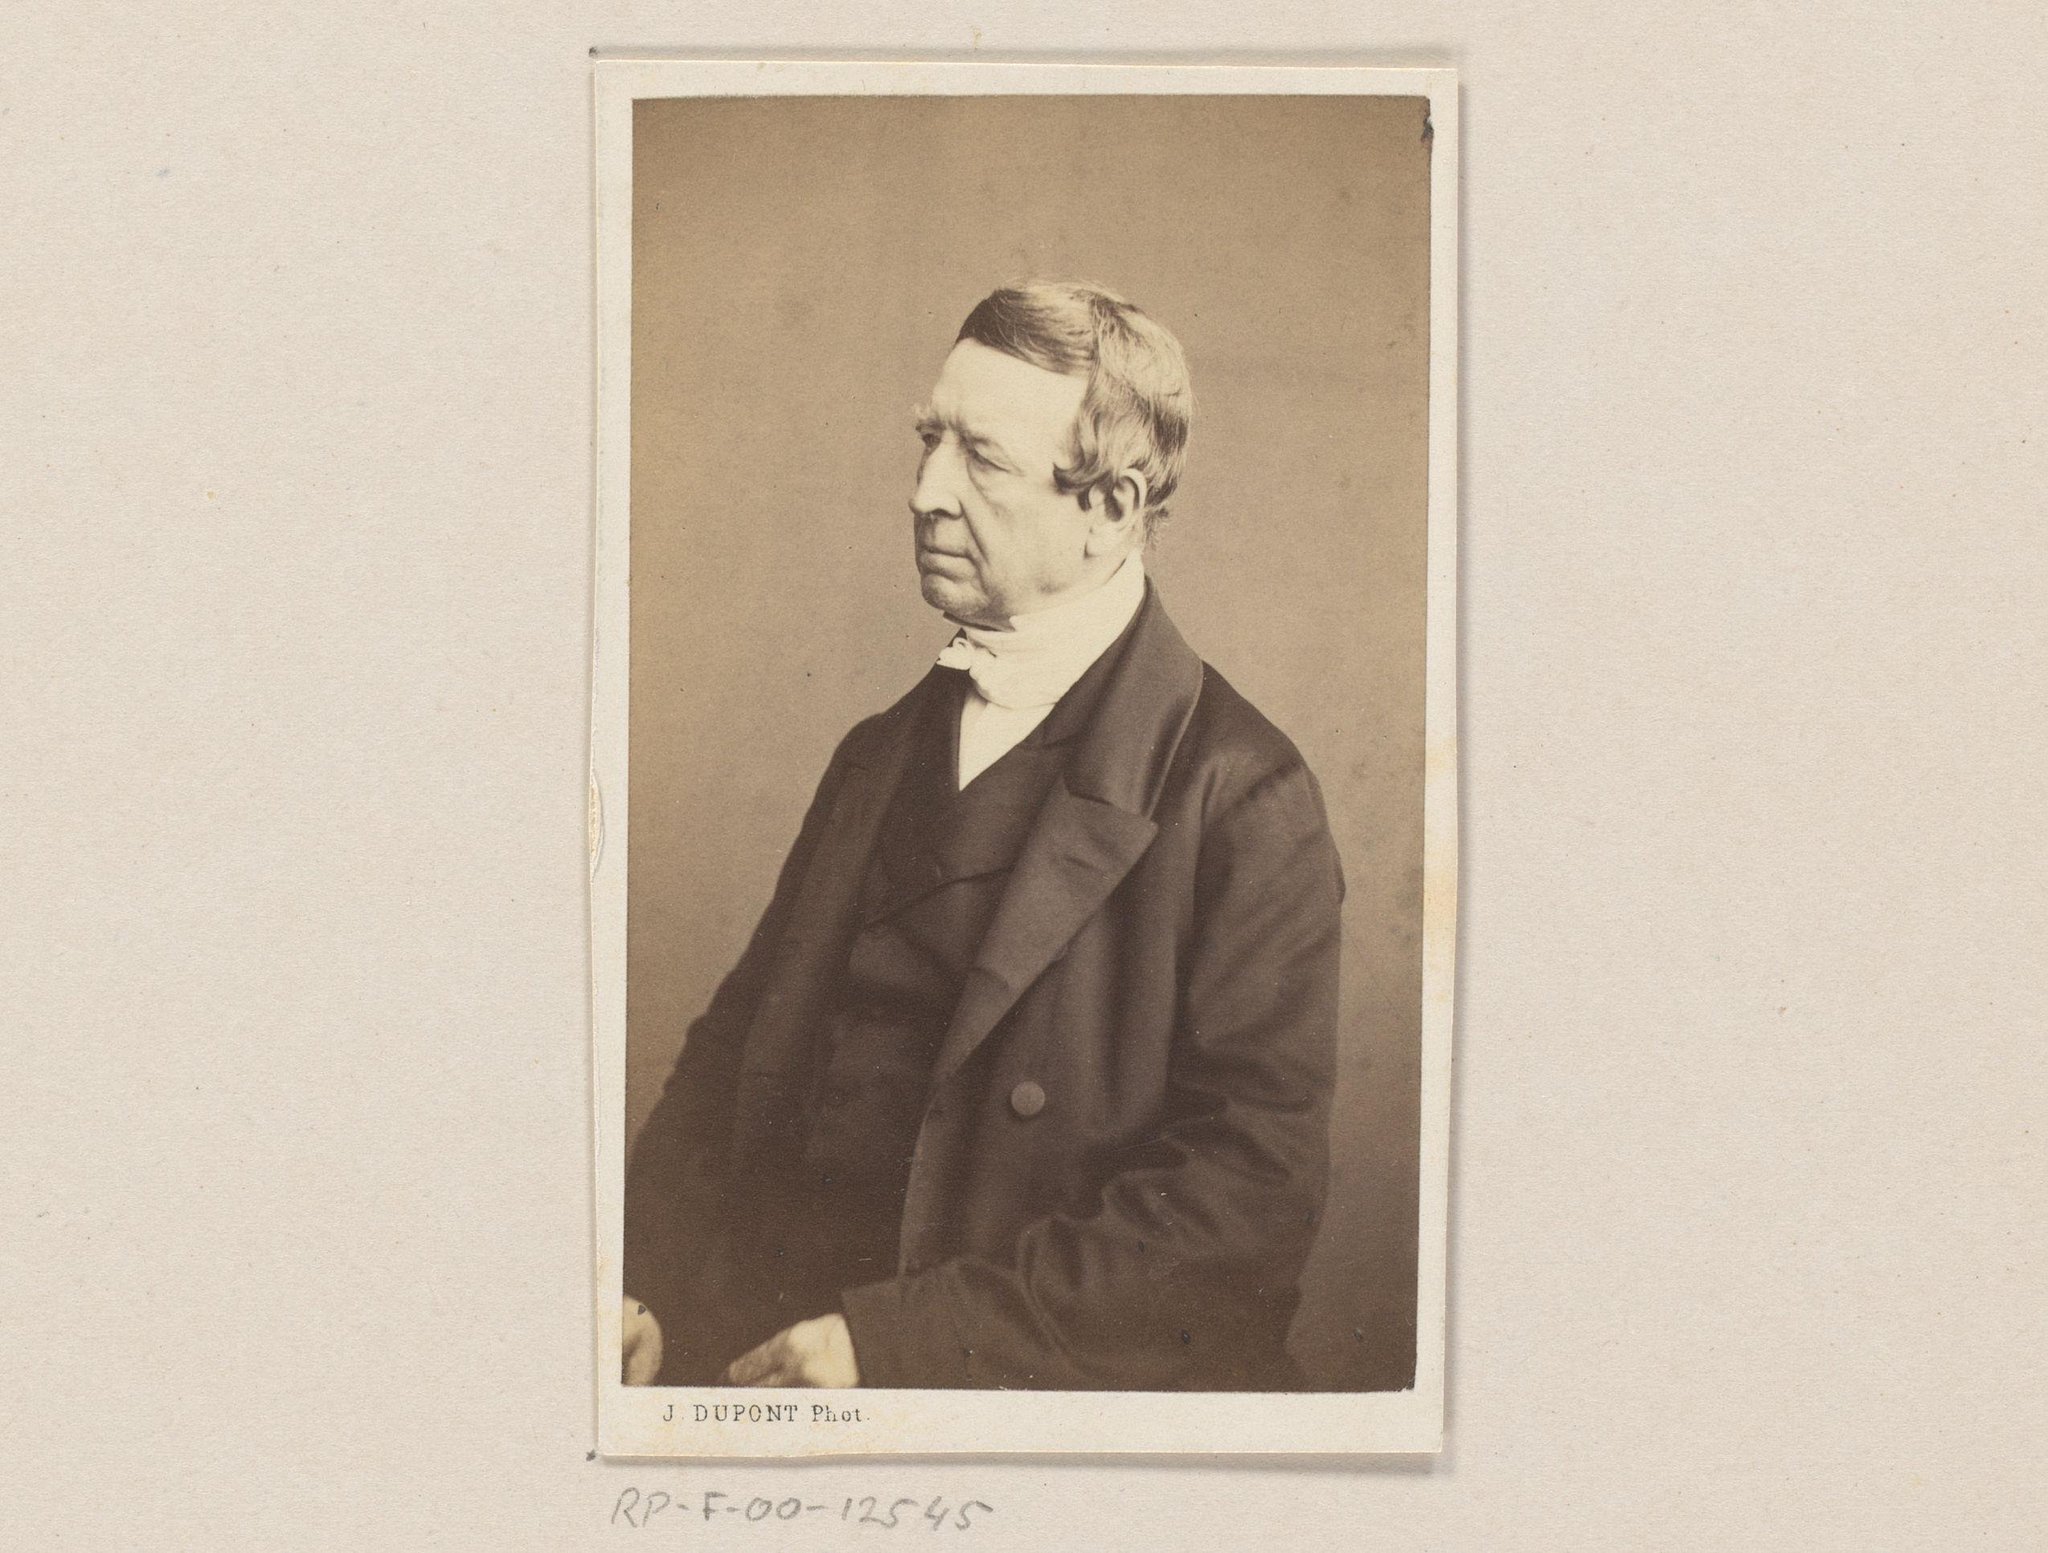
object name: photograph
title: Portret van Henri Van der Poorten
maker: joseph dupont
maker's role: fotograaf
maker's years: 1818-1901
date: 1859-1873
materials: cardboard, paper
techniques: albumen print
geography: antwerp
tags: antwerp, print maker, draughtsman, hendrik jozef franciscus van der poorten, historical persons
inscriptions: address: ‘Place de Meir, 32,/ ANVERS’